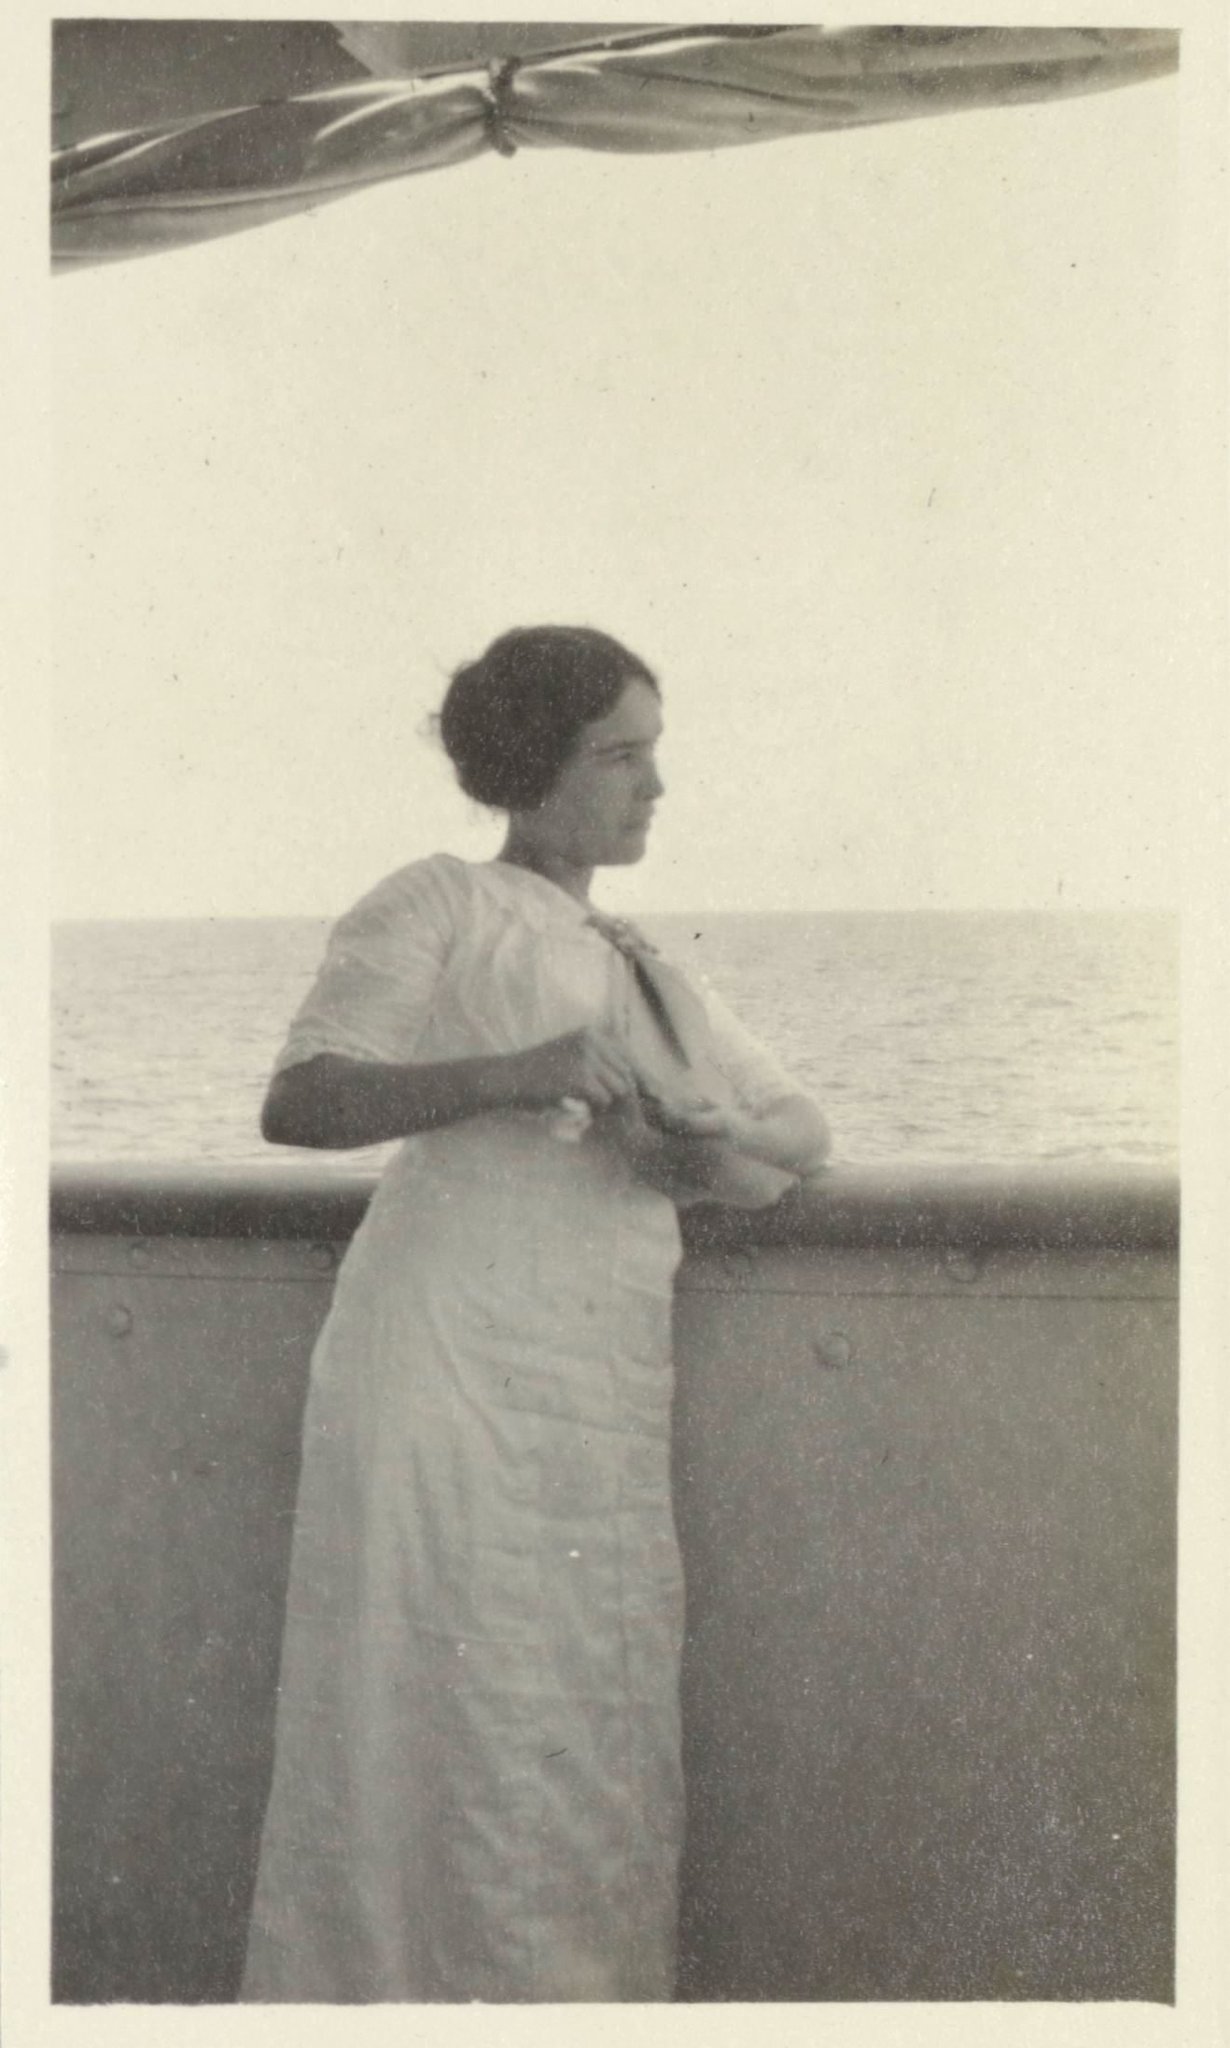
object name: photograph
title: Celia Gargollo, aan dek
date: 1908-1912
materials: photographic support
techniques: photography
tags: costa rica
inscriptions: inscription: ‘Celia Gargollo / San José de Costa Rica / Aug. '12 / S.S. Heredia’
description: Portret van Celia Gargollo, aan dek van het schip de S.S. Heredia, op zee in de omgeving van San José in Costa Rica, augustus 1912. Onderdeel van het fotoalbum van de familie Boom-Gonggrijp in Suriname en Curaçao.